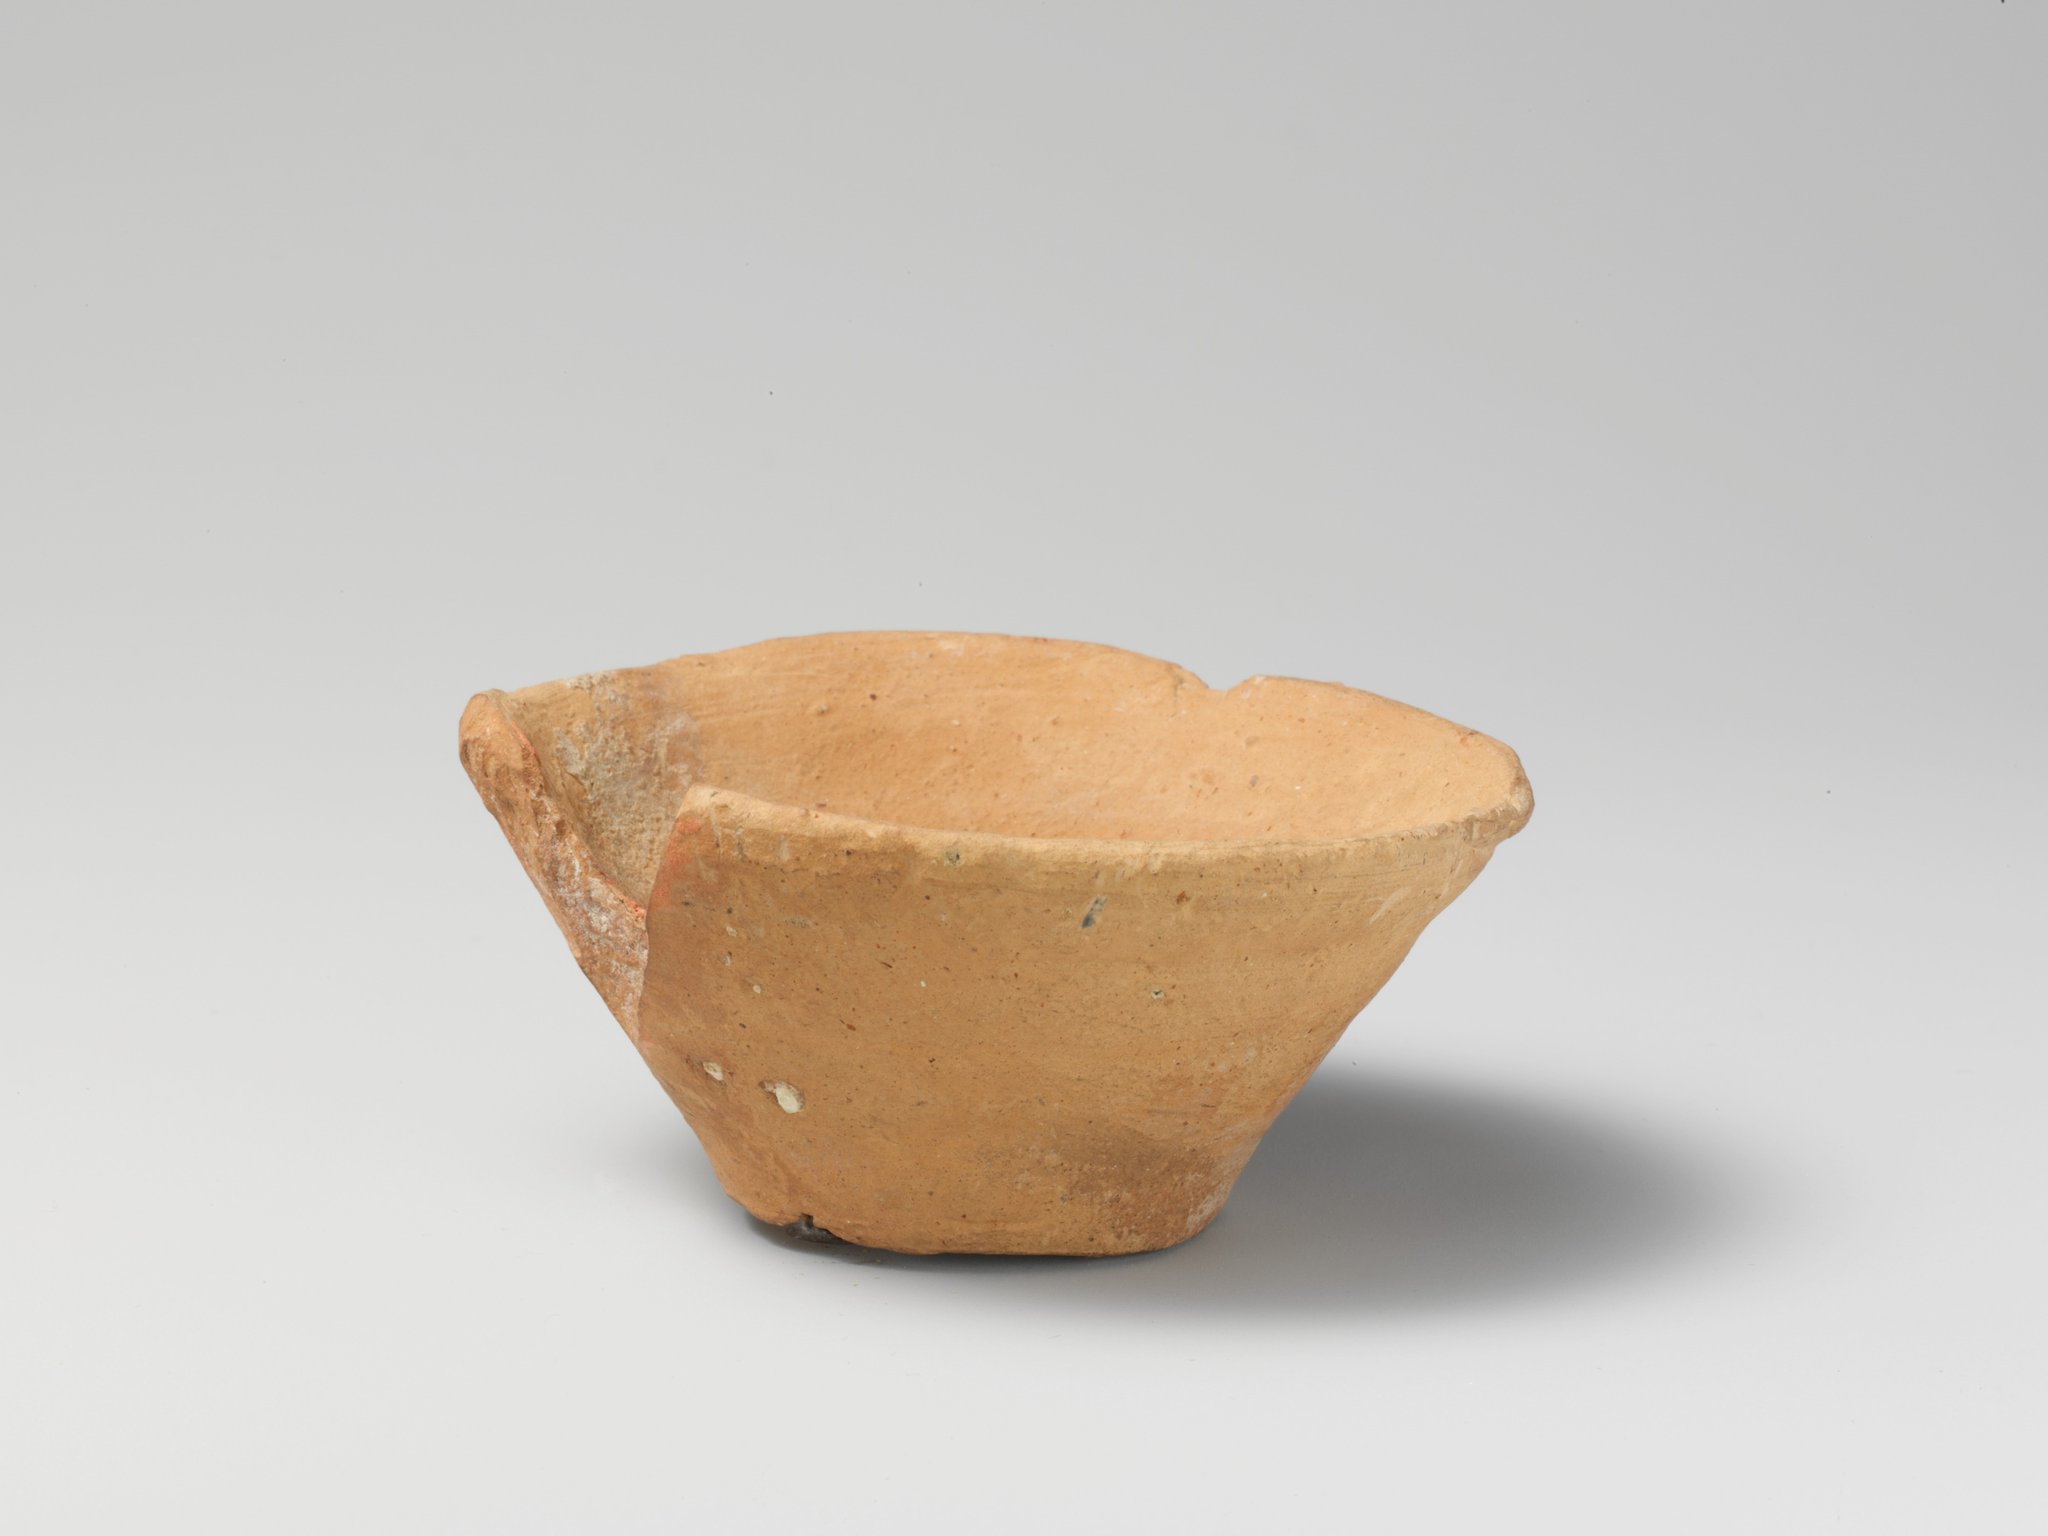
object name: vase fragment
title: Terracotta conical cup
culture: minoan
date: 2200-1900 BCE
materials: terracotta